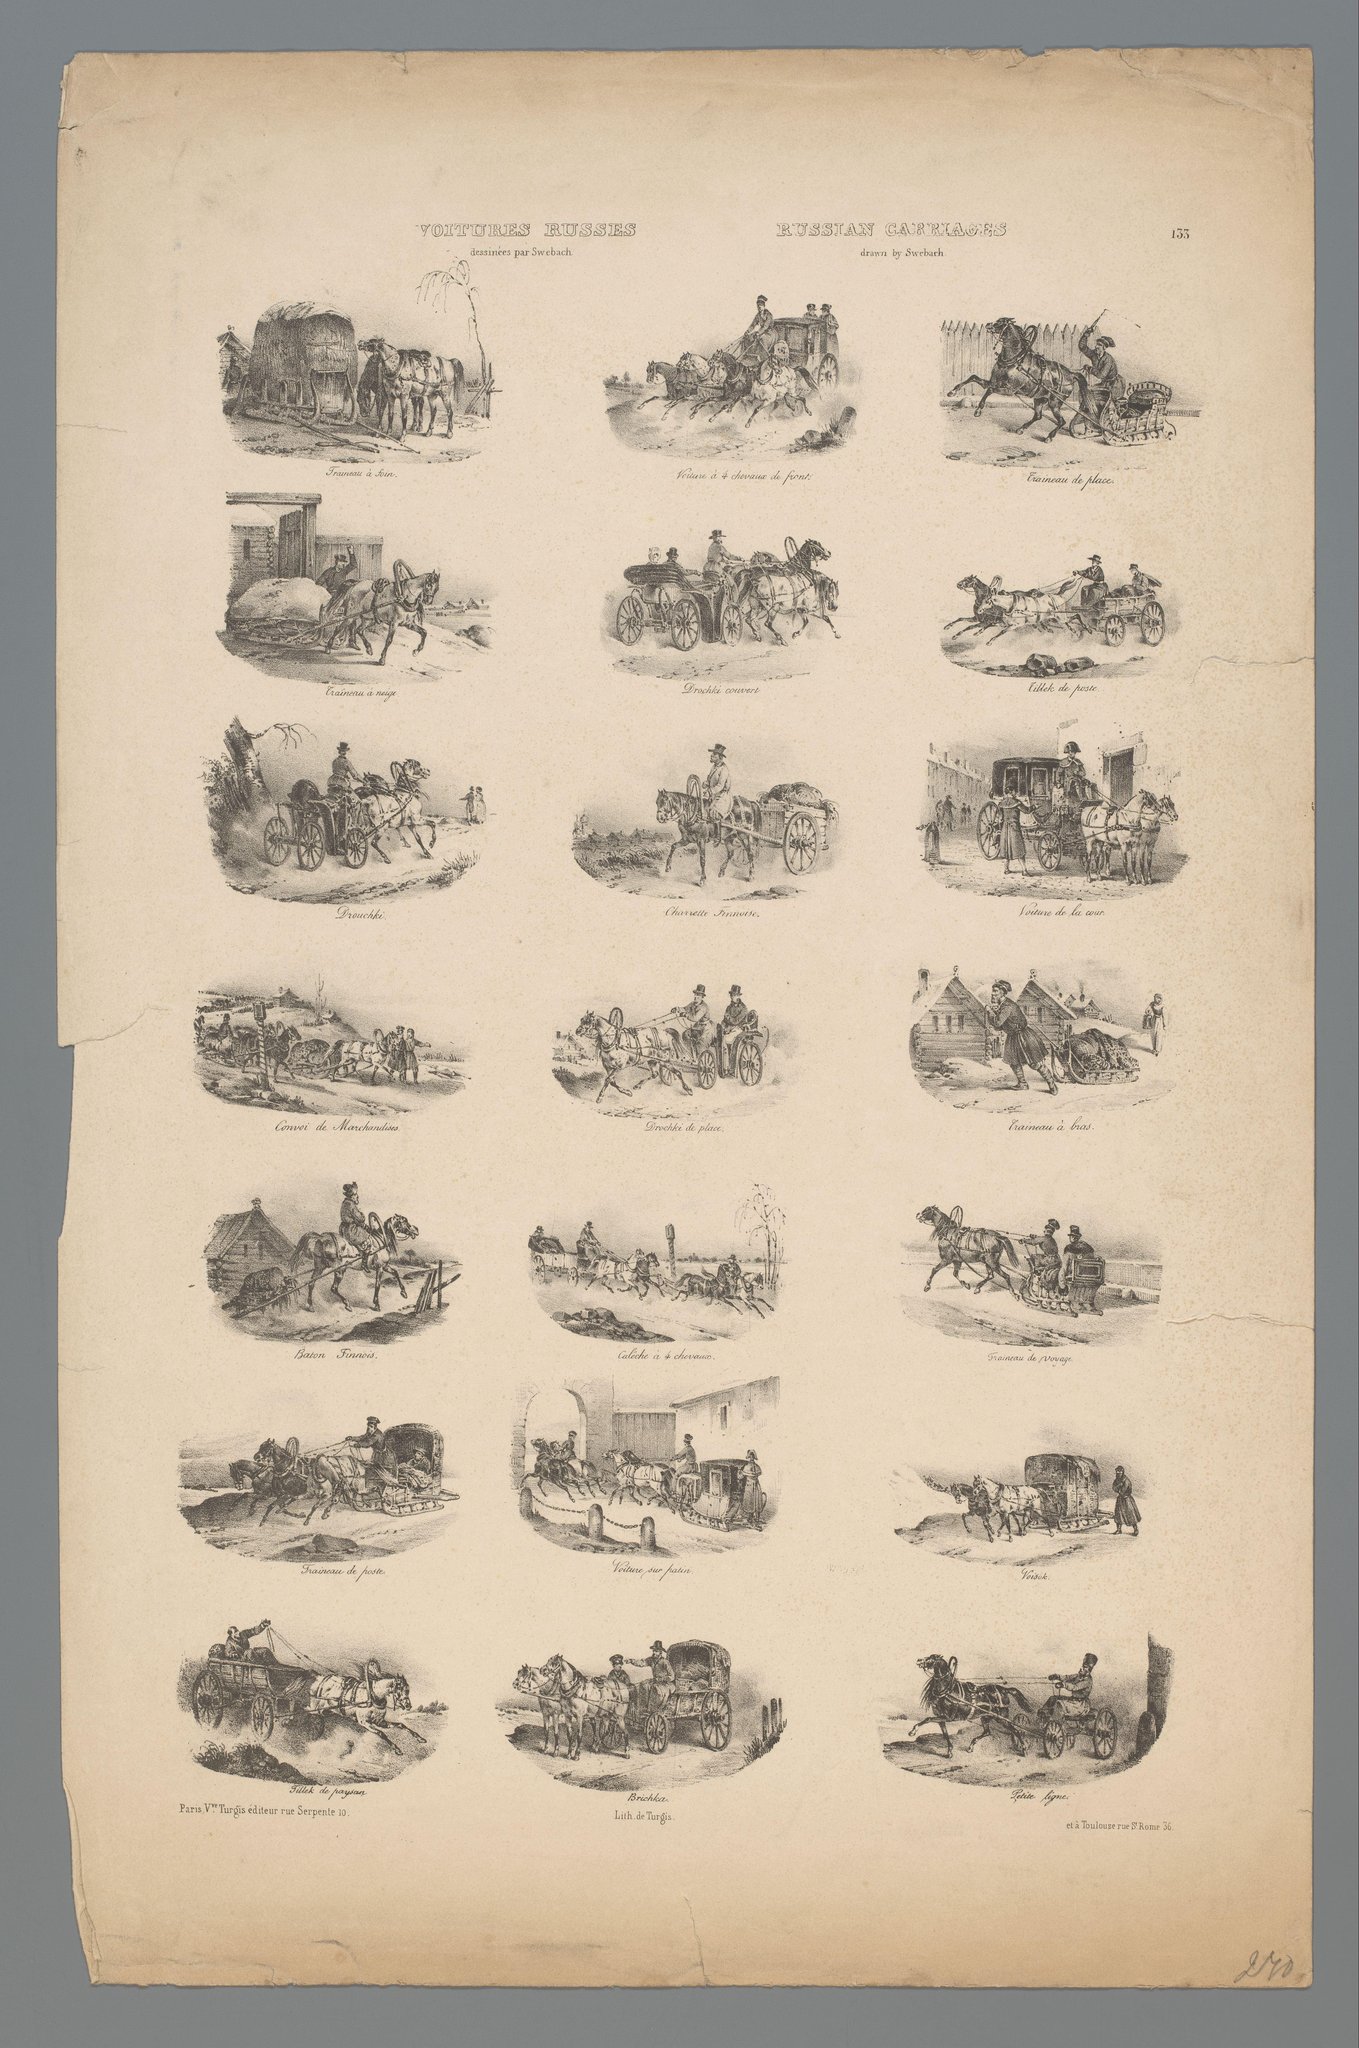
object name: print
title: Voitures russes / Russian carriages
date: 1833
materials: paper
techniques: lithograph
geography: toulouse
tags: horse-sleigh, four-wheeled, animal-drawn vehicle, e.g.: cab, carriage, coach, europeans (with name)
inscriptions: collector's mark: Lugt 2228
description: Eénentwintig voorstellingen op een blad. Rechtsboven genummerd: 133.